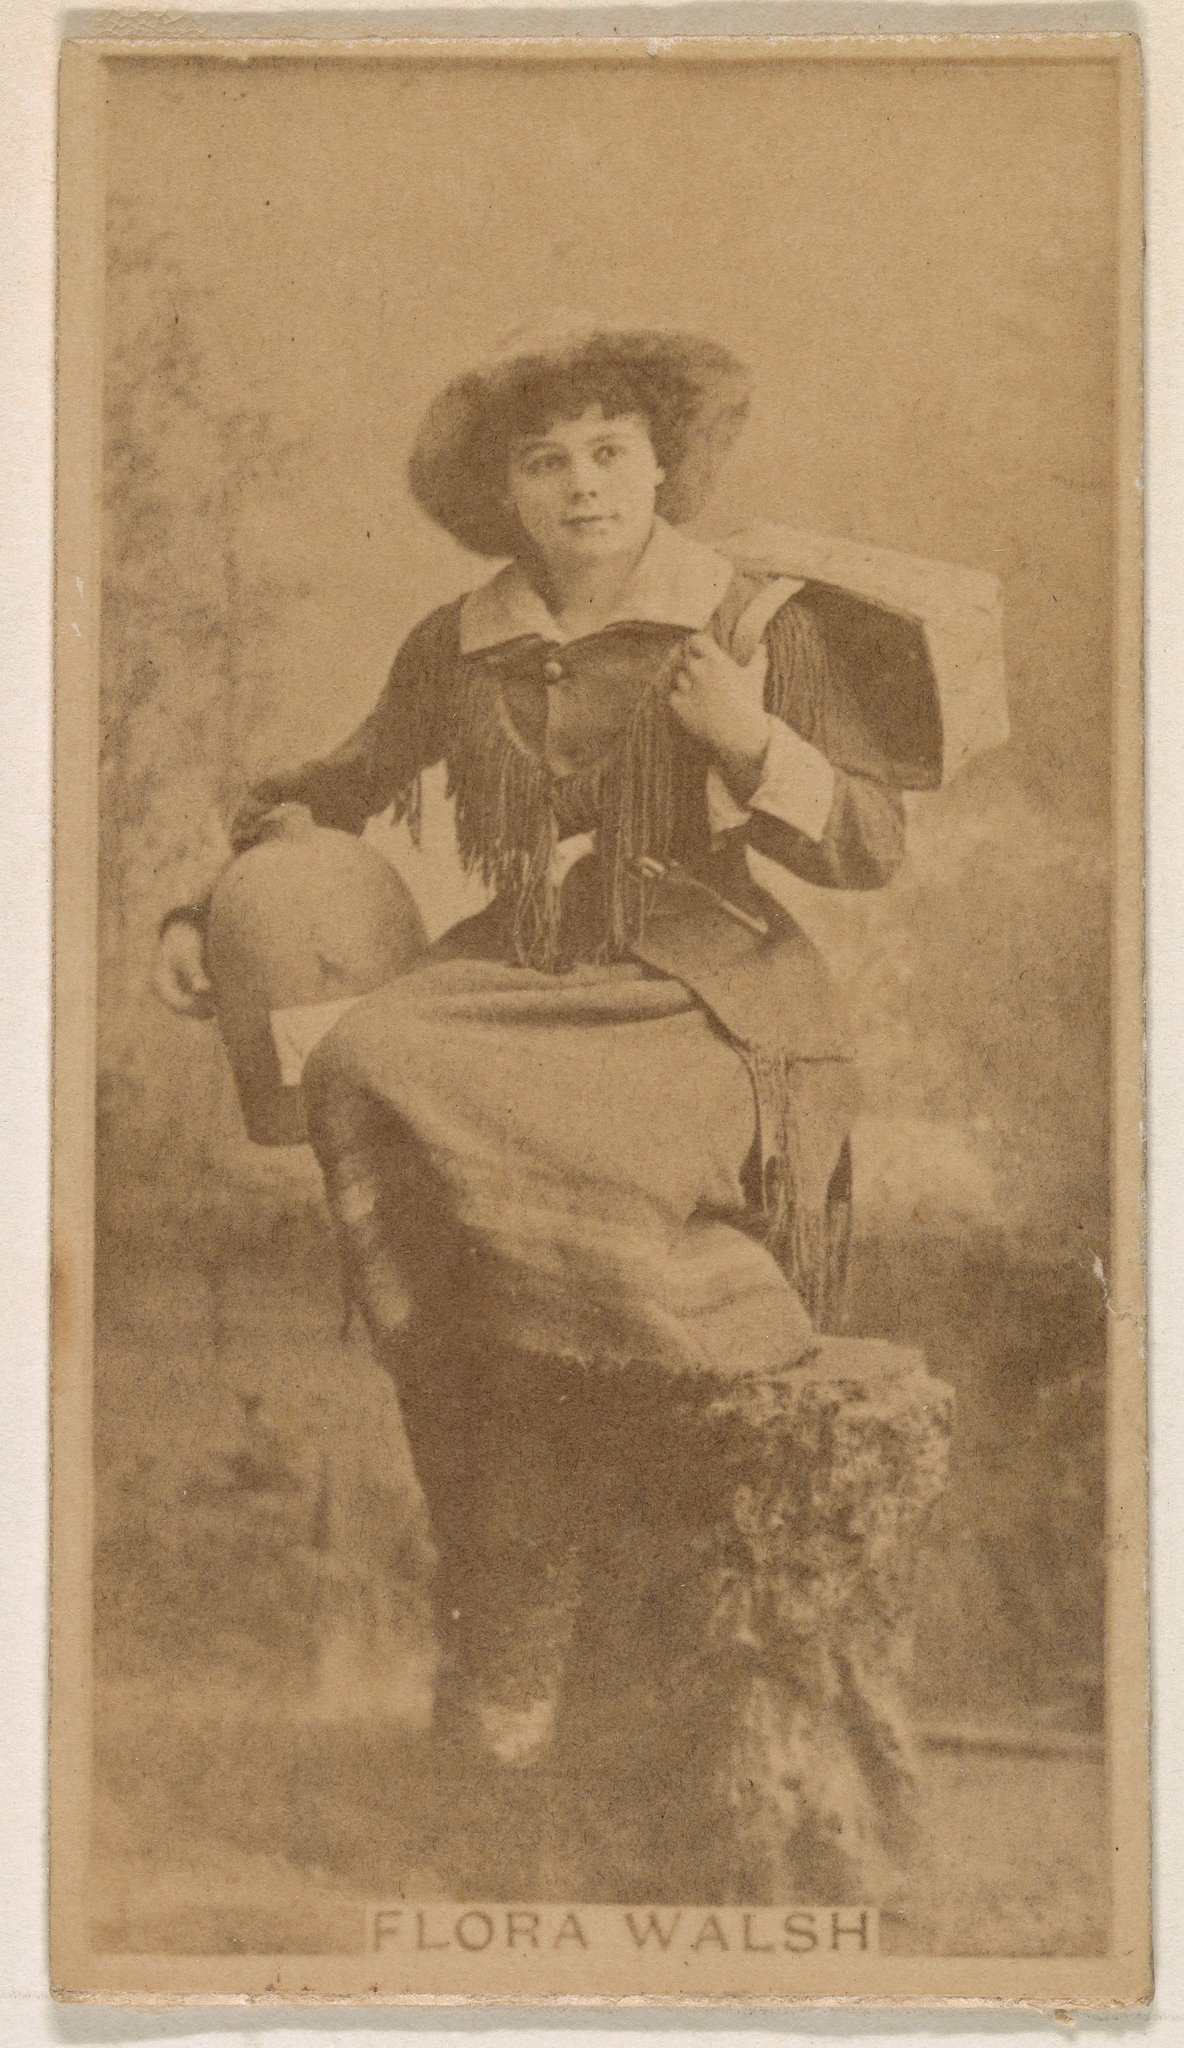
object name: photograph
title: Flora Walsh, from the Actresses series (N245) issued by Kinney Brothers to promote Sweet Caporal Cigarettes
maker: kinney brothers tobacco company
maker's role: publisher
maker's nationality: american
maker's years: 1869-2011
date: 1890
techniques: albumen silver print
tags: portraits,women,actresses